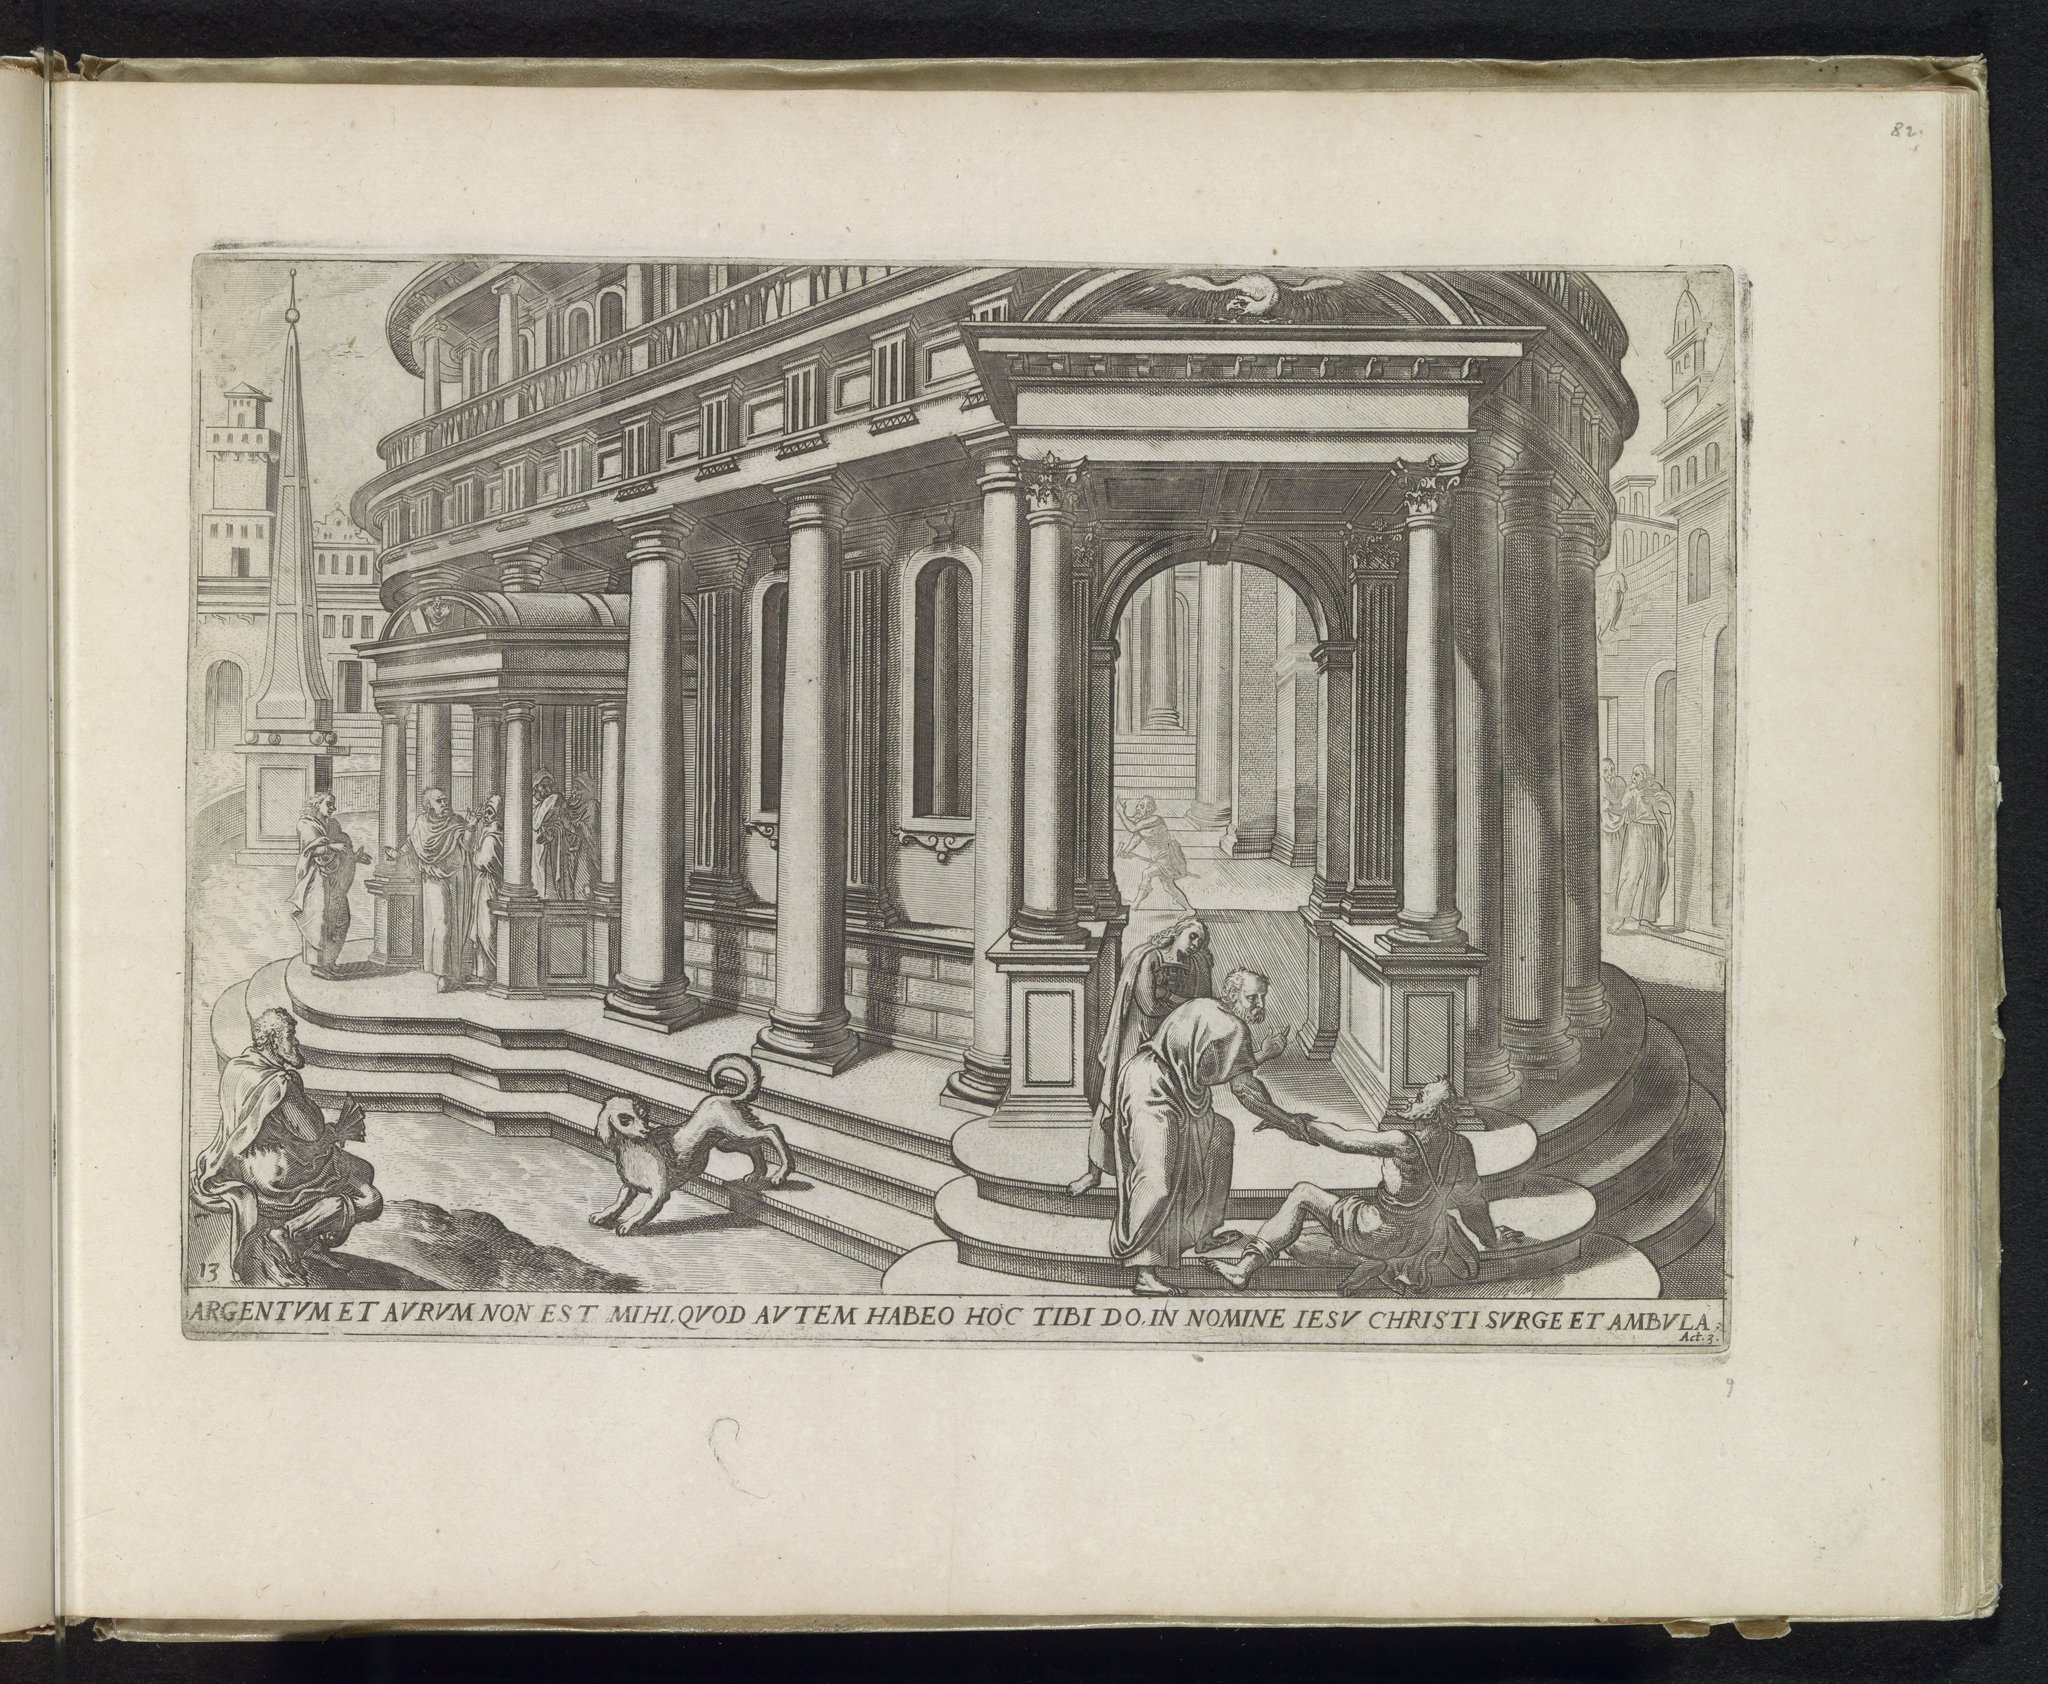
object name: album leaf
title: Peter and John heal a paralyzed man at the temple gate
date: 1585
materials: paper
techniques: engraving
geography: antwerp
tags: healing of a lame beggar at the beautiful gate of the temple by peter and john (acts 3 - 4:31), disabilities, deformations, peter, john and the healed man enter the temple, where peter delivers a sermon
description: De voorstelling is gebaseerd op de tekst uit Handelingen 3:4-31. In de Statenvertaling is de bedelaar beschreven als: “En een zeker man, die kreupel was van zijner moeders lijf, werd gedragen, welken zij dagelijks zetten aan de deur des tempels (…) Maar Petrus zei (…) In den Naam van Jezus Christus den Nazaréner, sta op en wandel. En hem grijpende bij de rechterhand, richtte hij hem op, en terstond werden zijn voeten en enkels vast”. In de Nieuwe Bijbelvertaling wordt er niet gesproken over ‘kreupel’ maar over verlamming: “Men had ook een man die al sinds zijn geboorte verlamd was naar de tempel gebracht (…) Maar Petrus zei (…) in de naam van Jezus Christus van Nazareth, sta op en loop.’ Hij pakte hem bij zijn rechterhand om hem overeind te helpen. Onmiddellijk kwam er kracht in zijn voeten en enkels.”